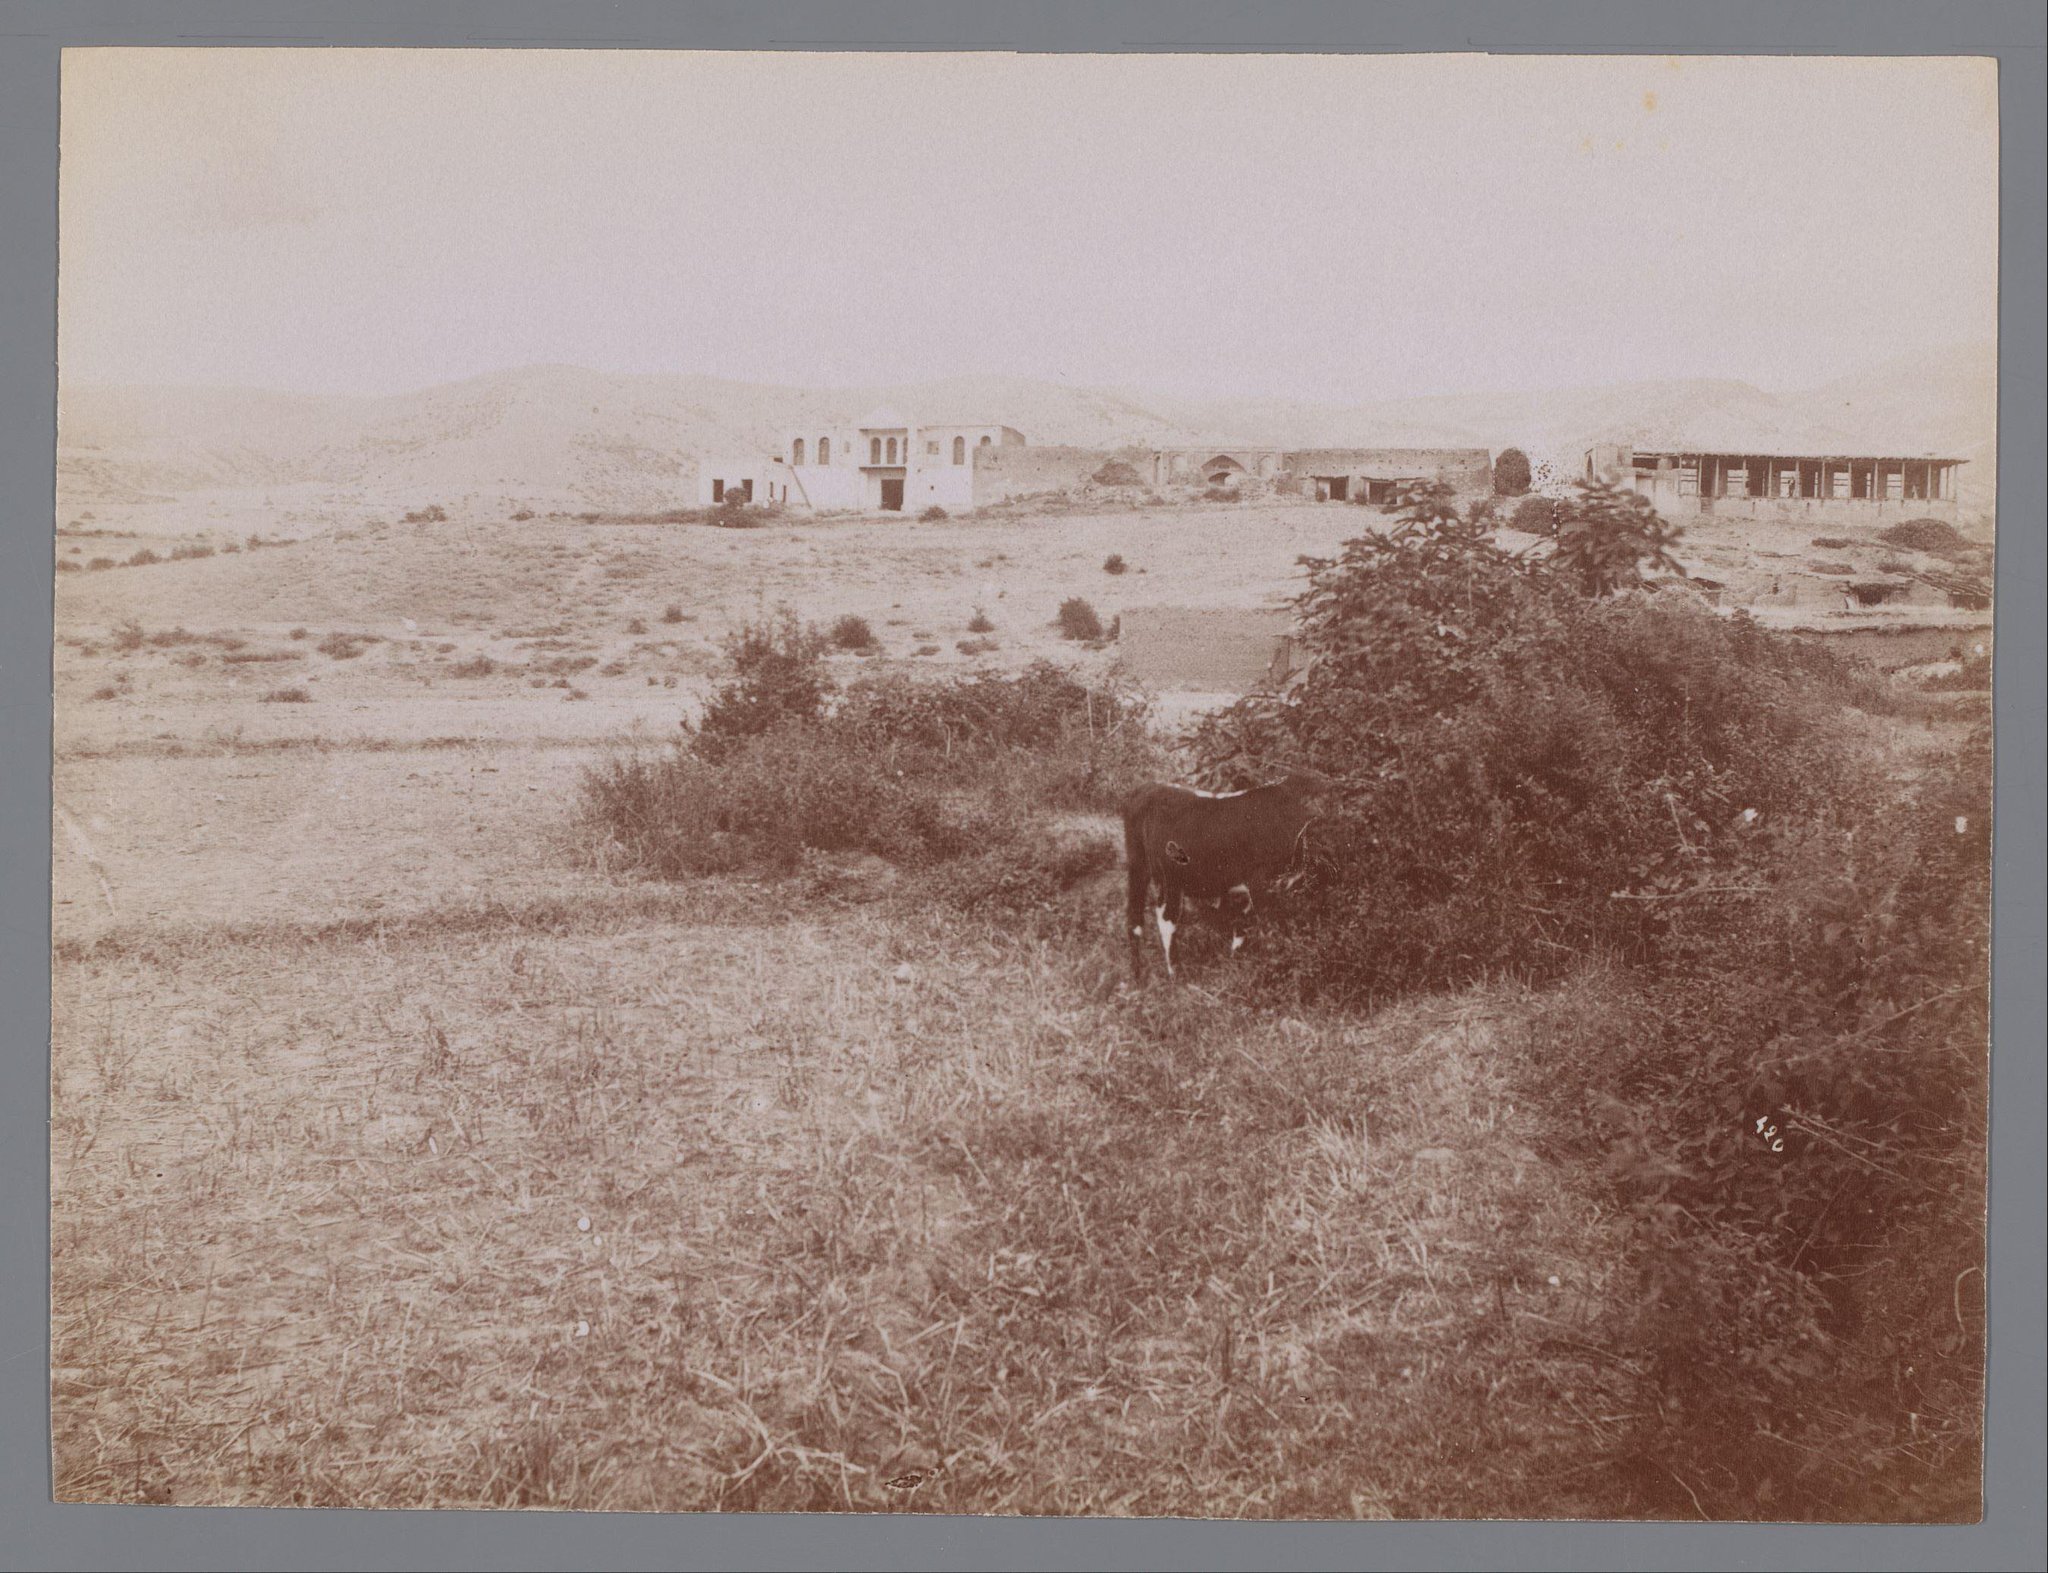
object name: photograph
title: Landschap, "La route de Rescht", Iran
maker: antoine sevruguin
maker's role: fotograaf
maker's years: 1840-1933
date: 1885-1910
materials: paper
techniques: albumen print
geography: iran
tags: iran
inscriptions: inscription: ‘La route de Rescht//Roustemabail [?]’, number: ‘10.’, number: ‘420’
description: Graslandschap, "La route de Rescht", Iran. Vlak landschap met huizen op de achtergrond en een koe bij een struik op de voorgrond.